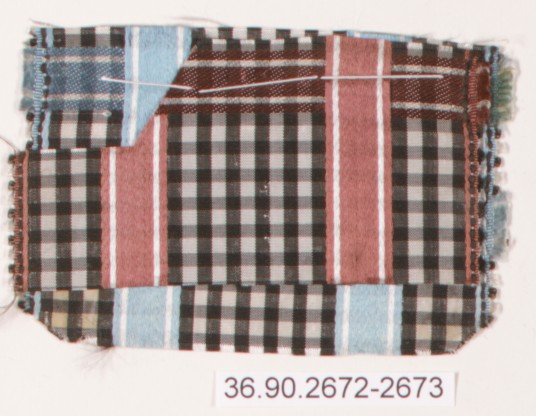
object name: ribbon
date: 1801-1900